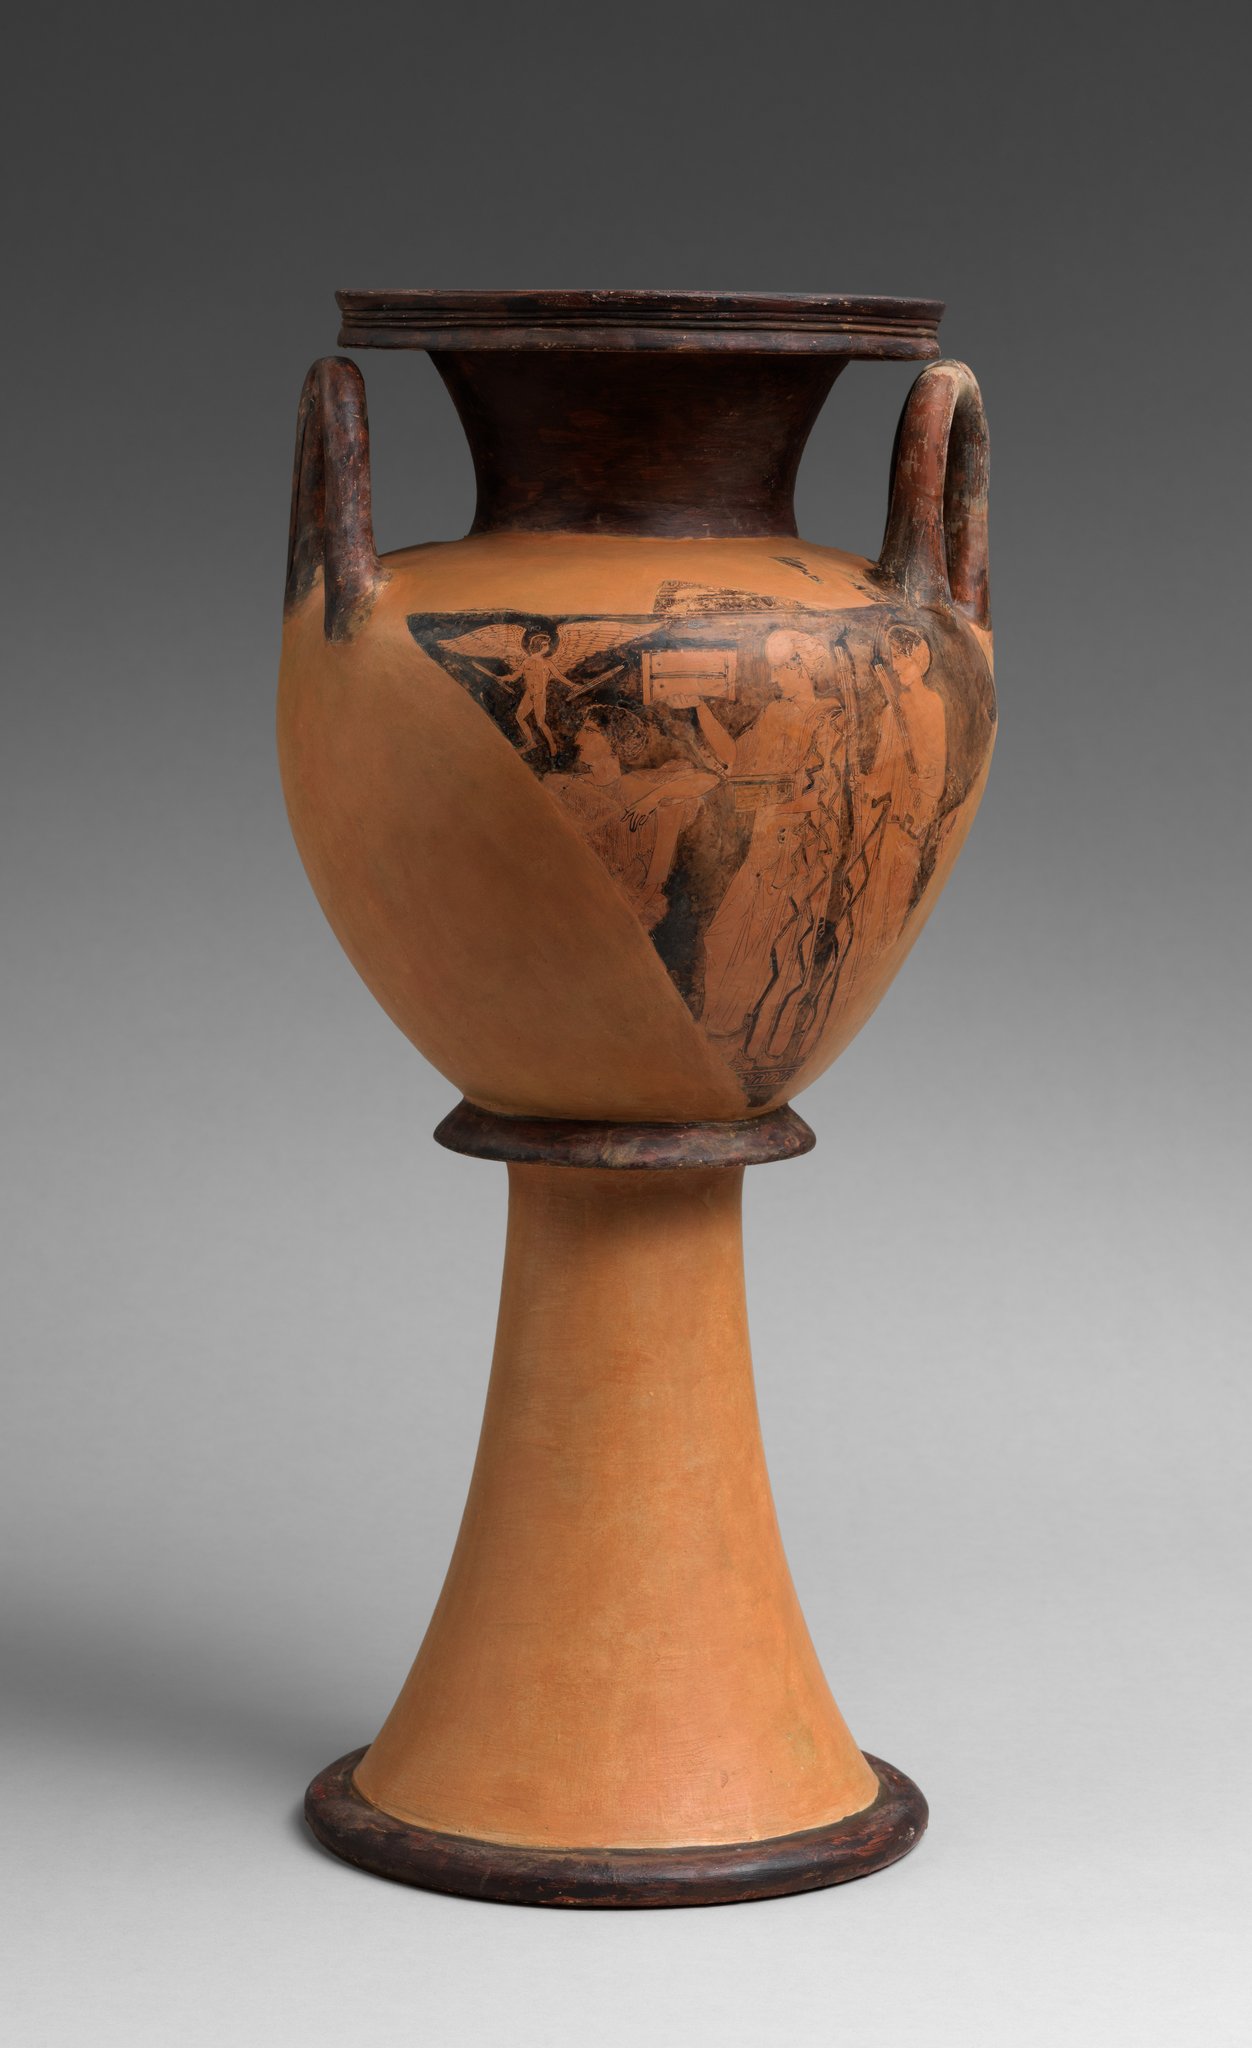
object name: lebes gamikos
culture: greek, attic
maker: washing painter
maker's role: artist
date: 430-420 BCE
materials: terracotta